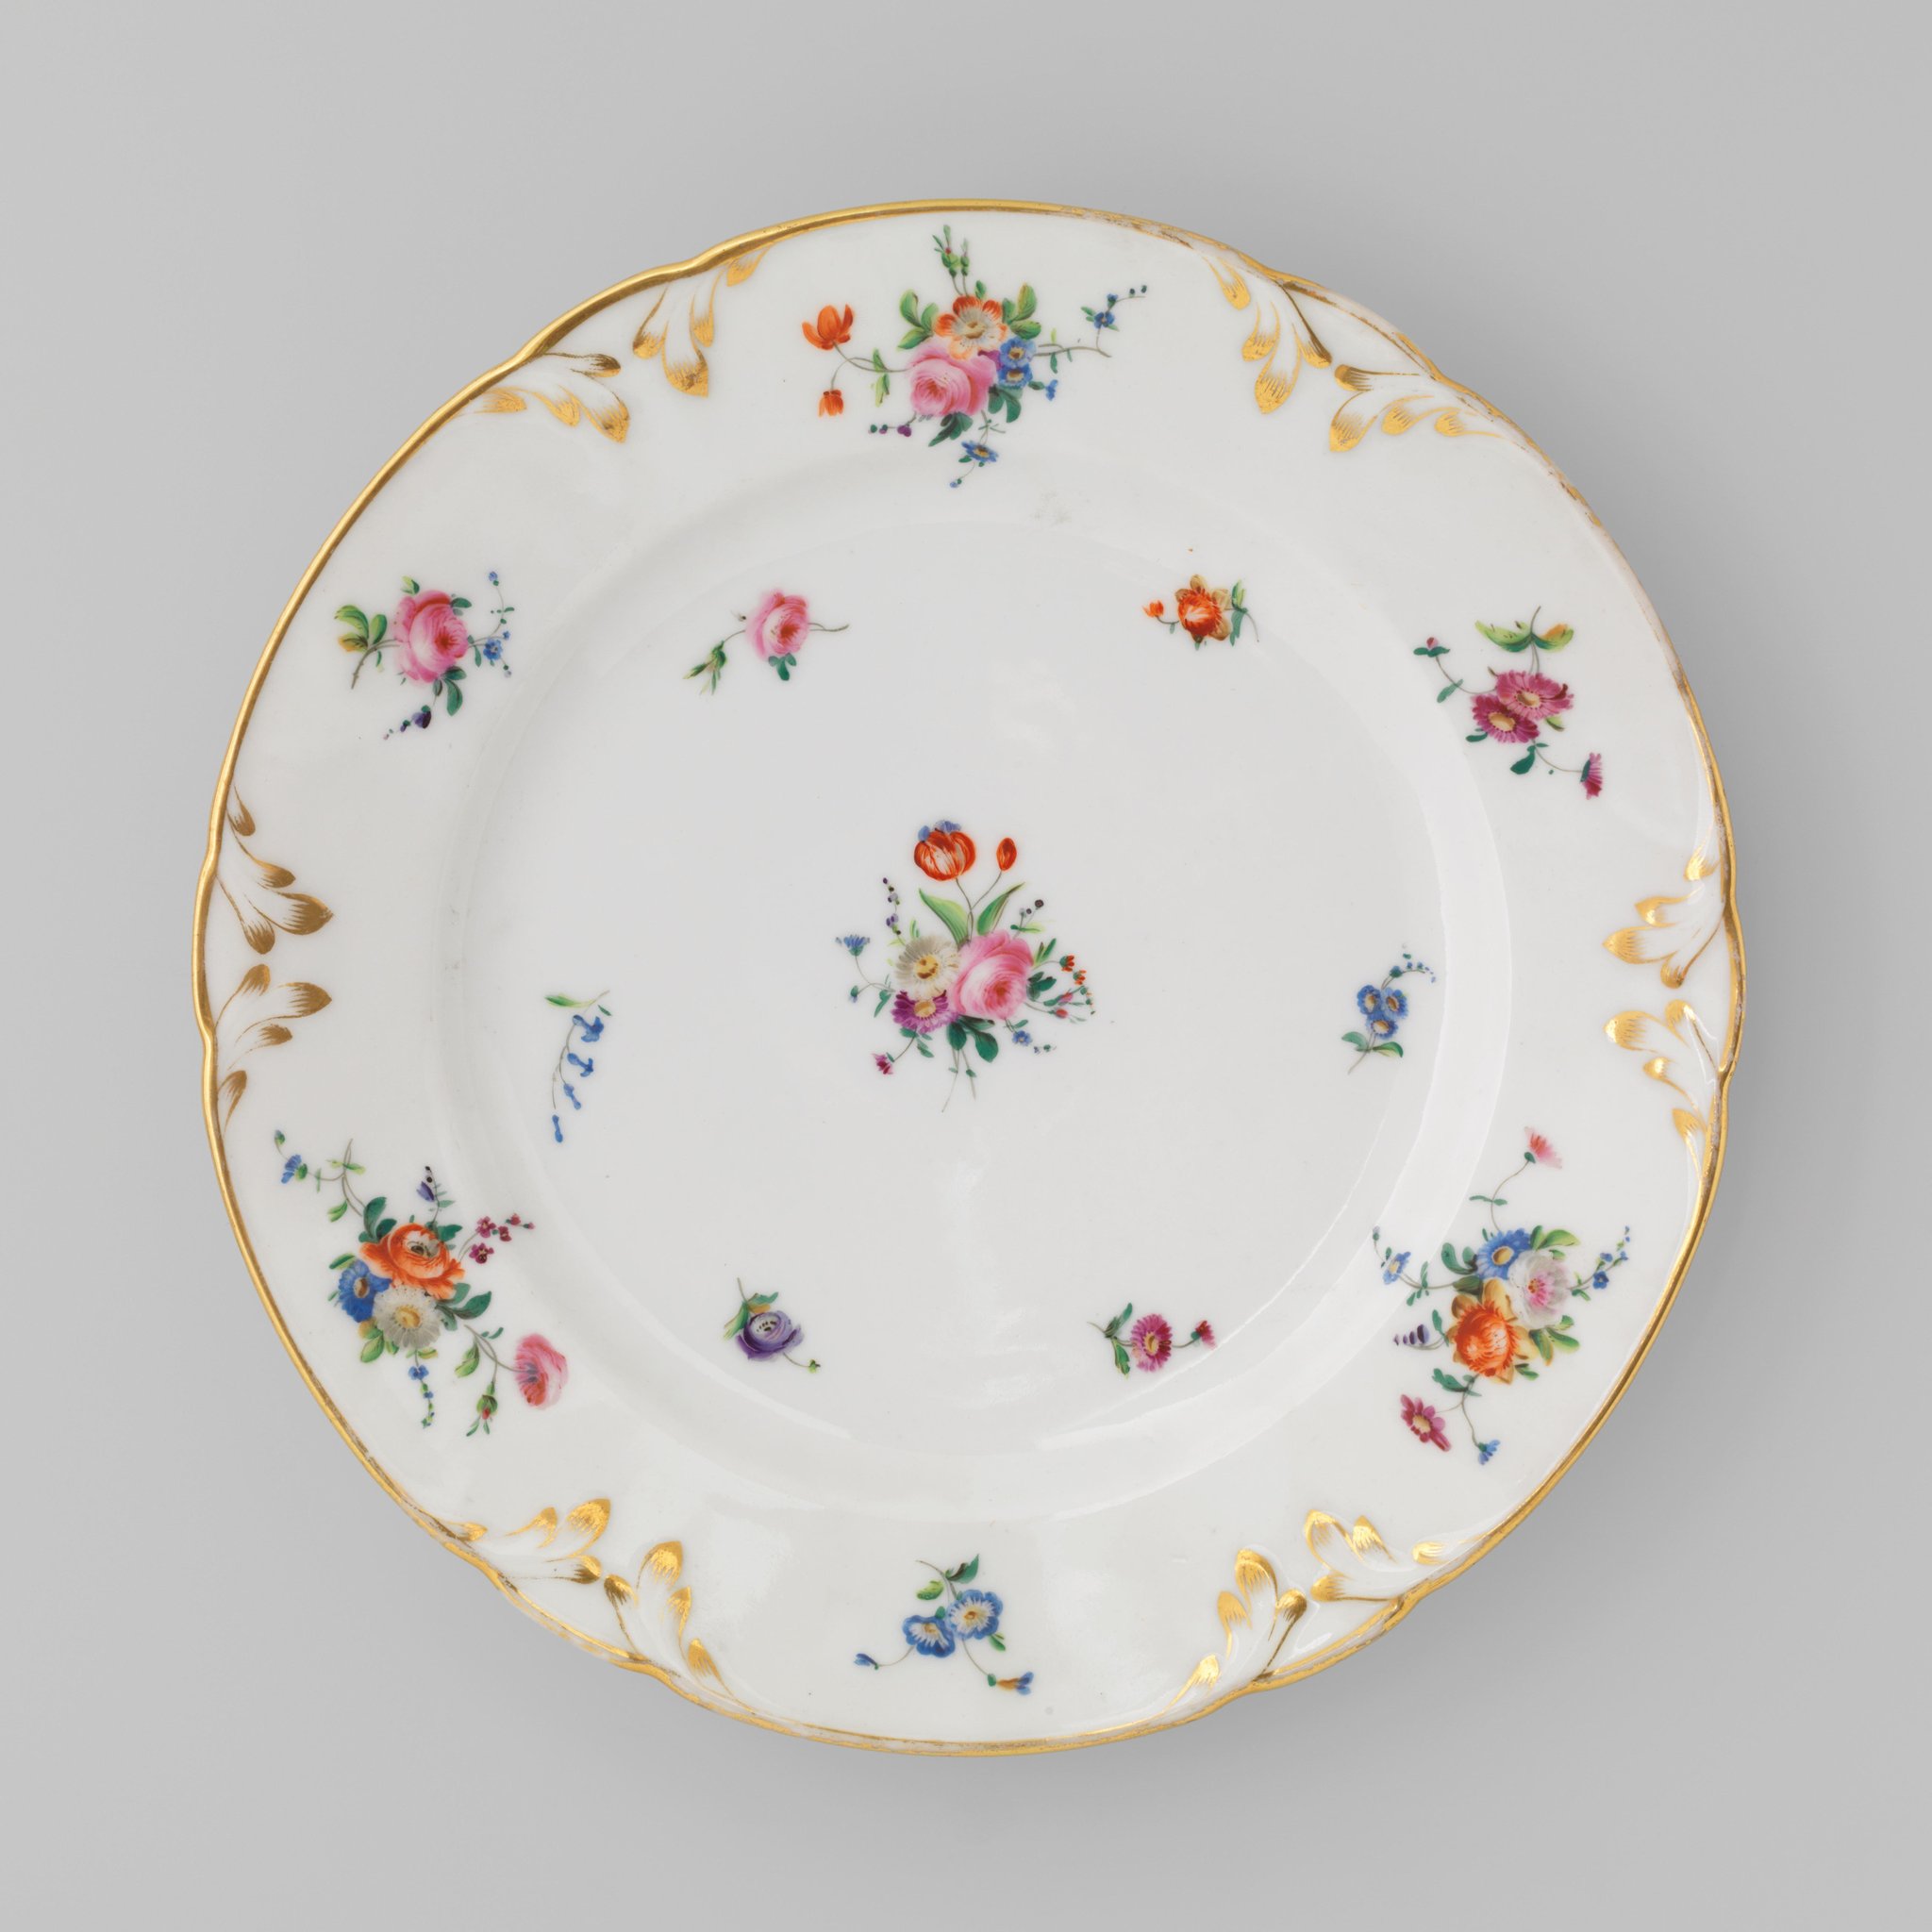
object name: plate dish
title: Plate with bouquets and flower sprays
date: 1839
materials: glaze, gold, paint, porcelain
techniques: firing, forming, gilding, turning, vitrification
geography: paris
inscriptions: mark: ‘DENUELLE/ Boulevard St. Denis 18/ à Paris’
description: Bord (dessertbord) van porselein met een gelobde rand, beschilderd op het glazuur in blauw, rood, roze, groen, geel, paars, zwart en goud. Op het plat boeketten van verschillende bloemen en strooibloemen. Vanuit de gelobde, gouden rand, gemodelleerde bladranken in reliëf, aangezet met goud. Hiertussen boeketten. Drie proenen op de onderzijde. Gemerkt op de onderzijde met 'DENUELLE/ Boulevard St. Denis 18/ à Paris'.